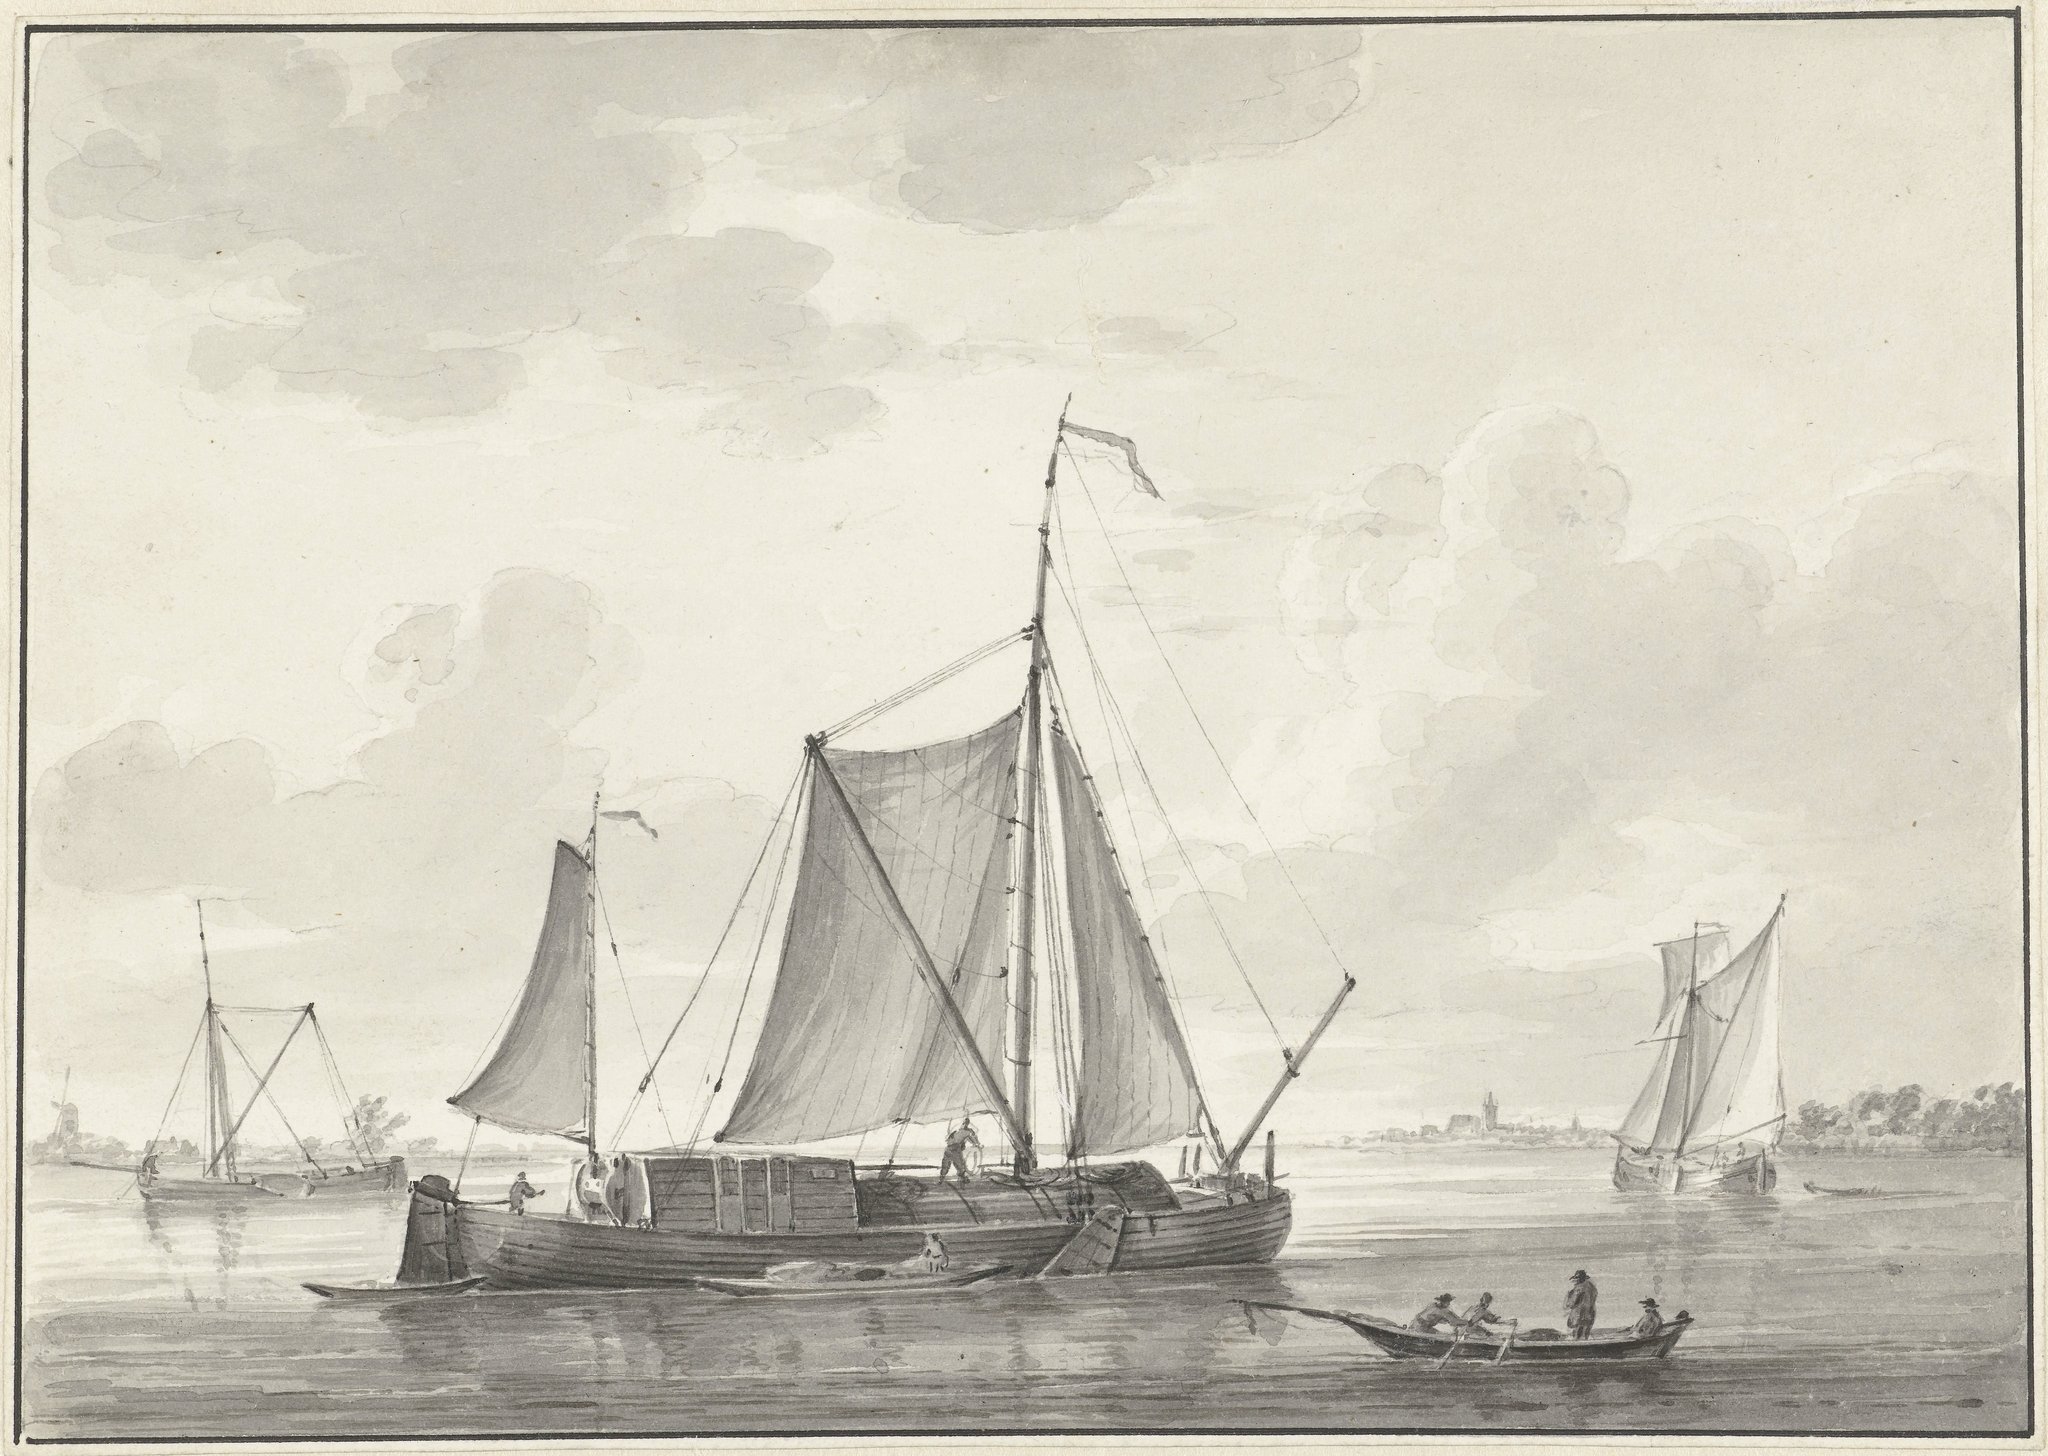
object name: drawing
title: Boten op het water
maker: gerrit groenewegen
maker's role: draughtsman, print maker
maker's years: 1754-1826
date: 1791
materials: chalk, ink, paper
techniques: brush, pen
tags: sailing-ship, sailing-boat, river